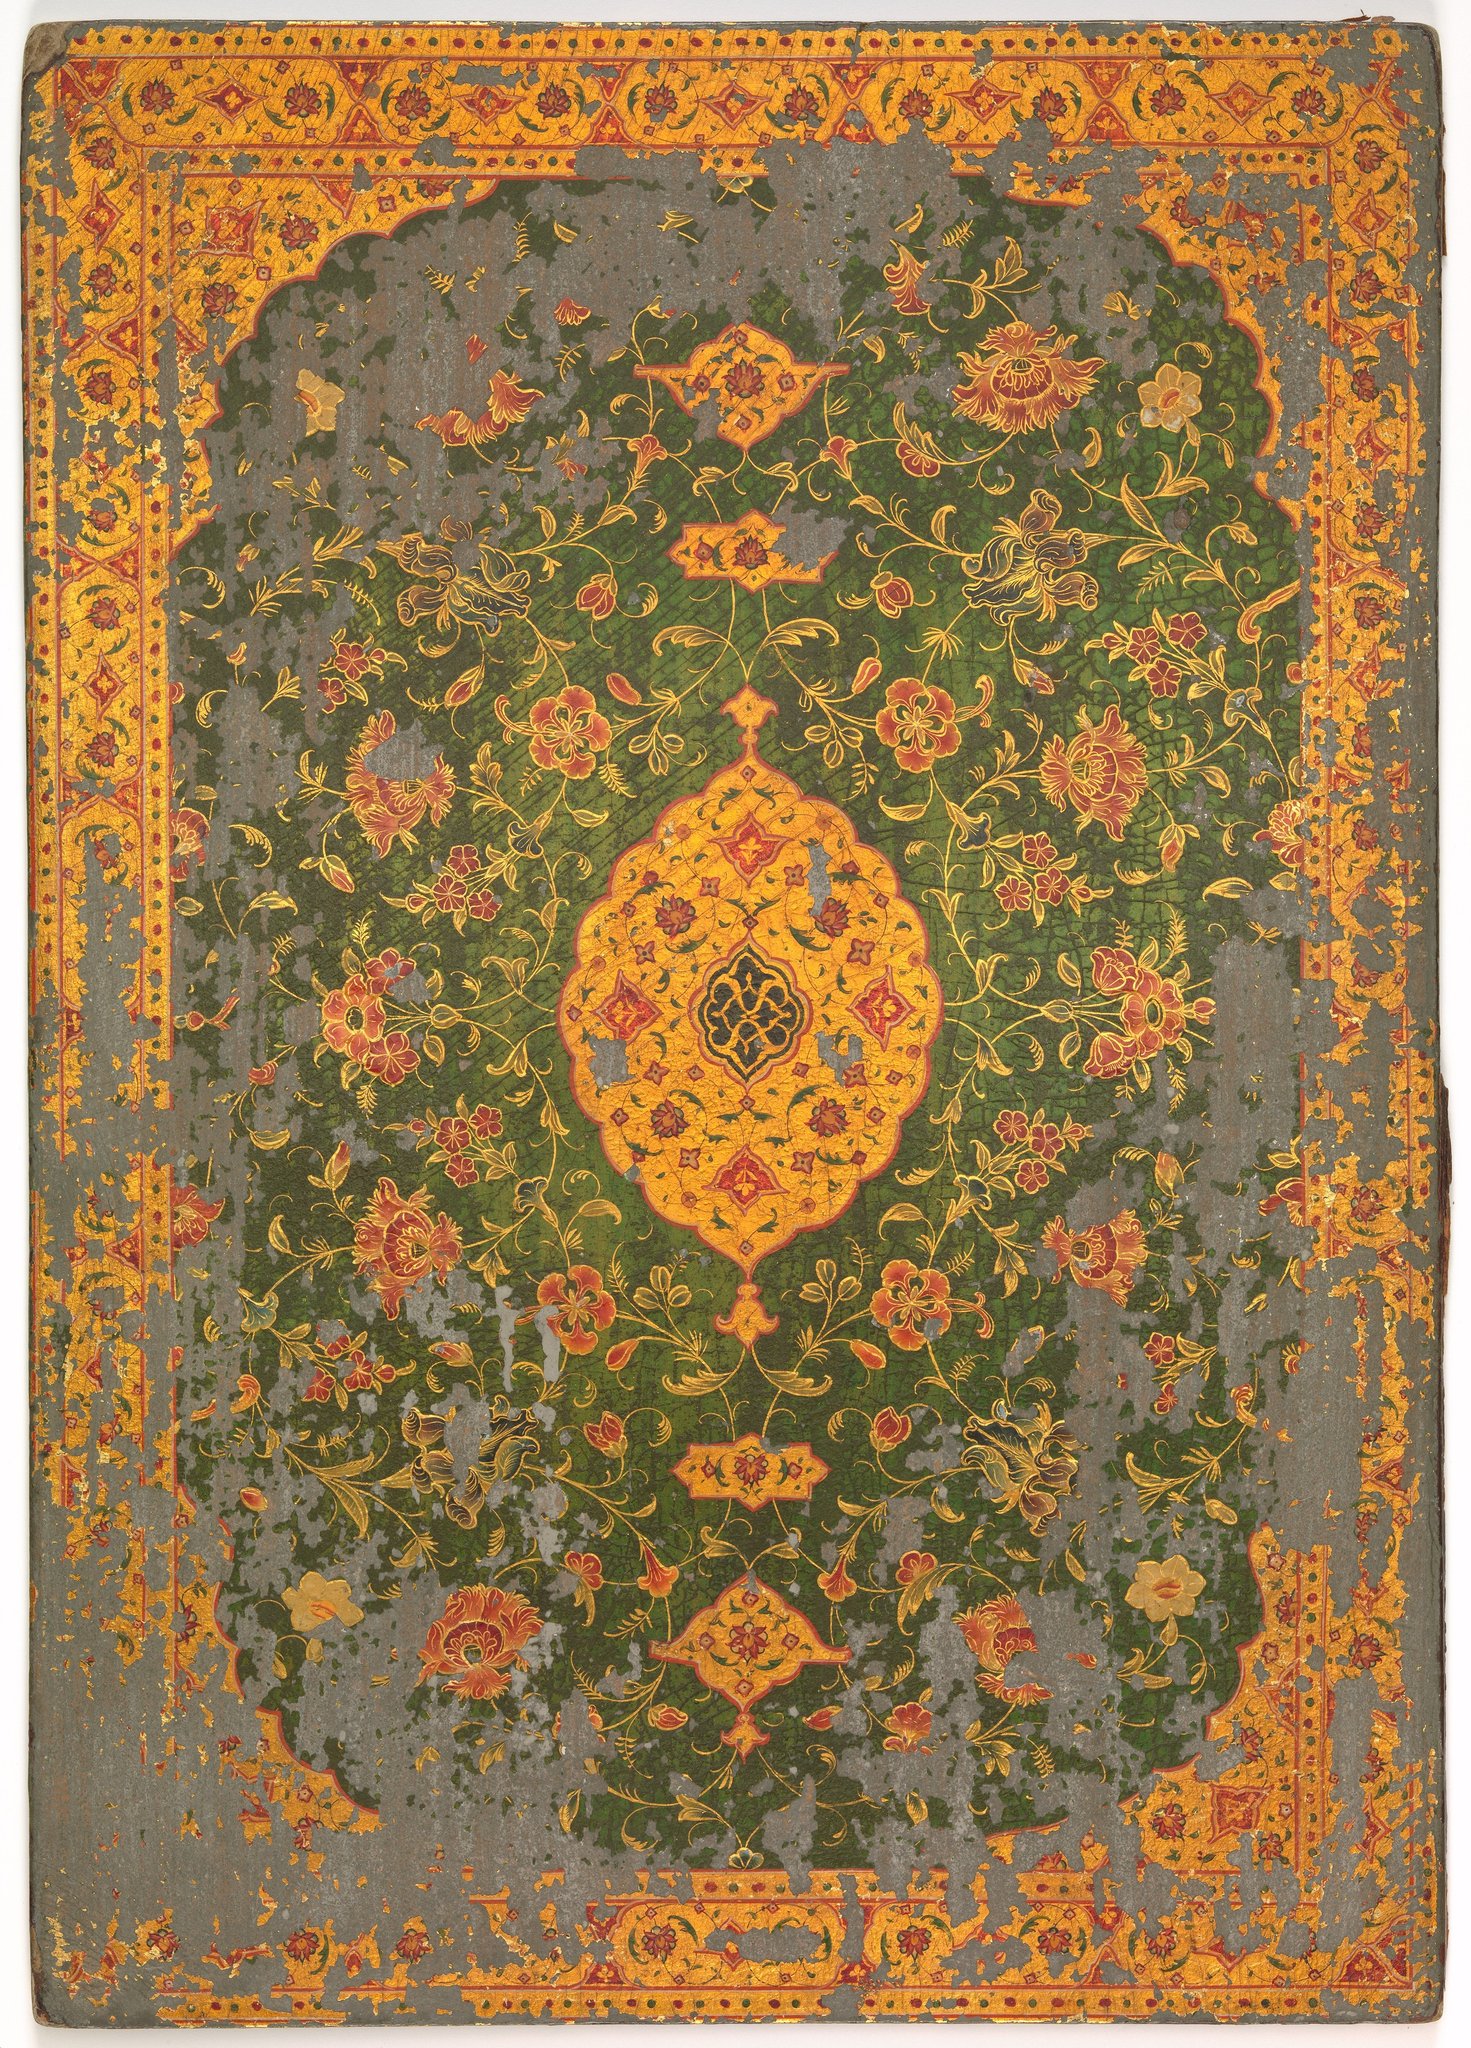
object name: bookbinding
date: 1601-1700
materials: board, leather, paper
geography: india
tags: flowers